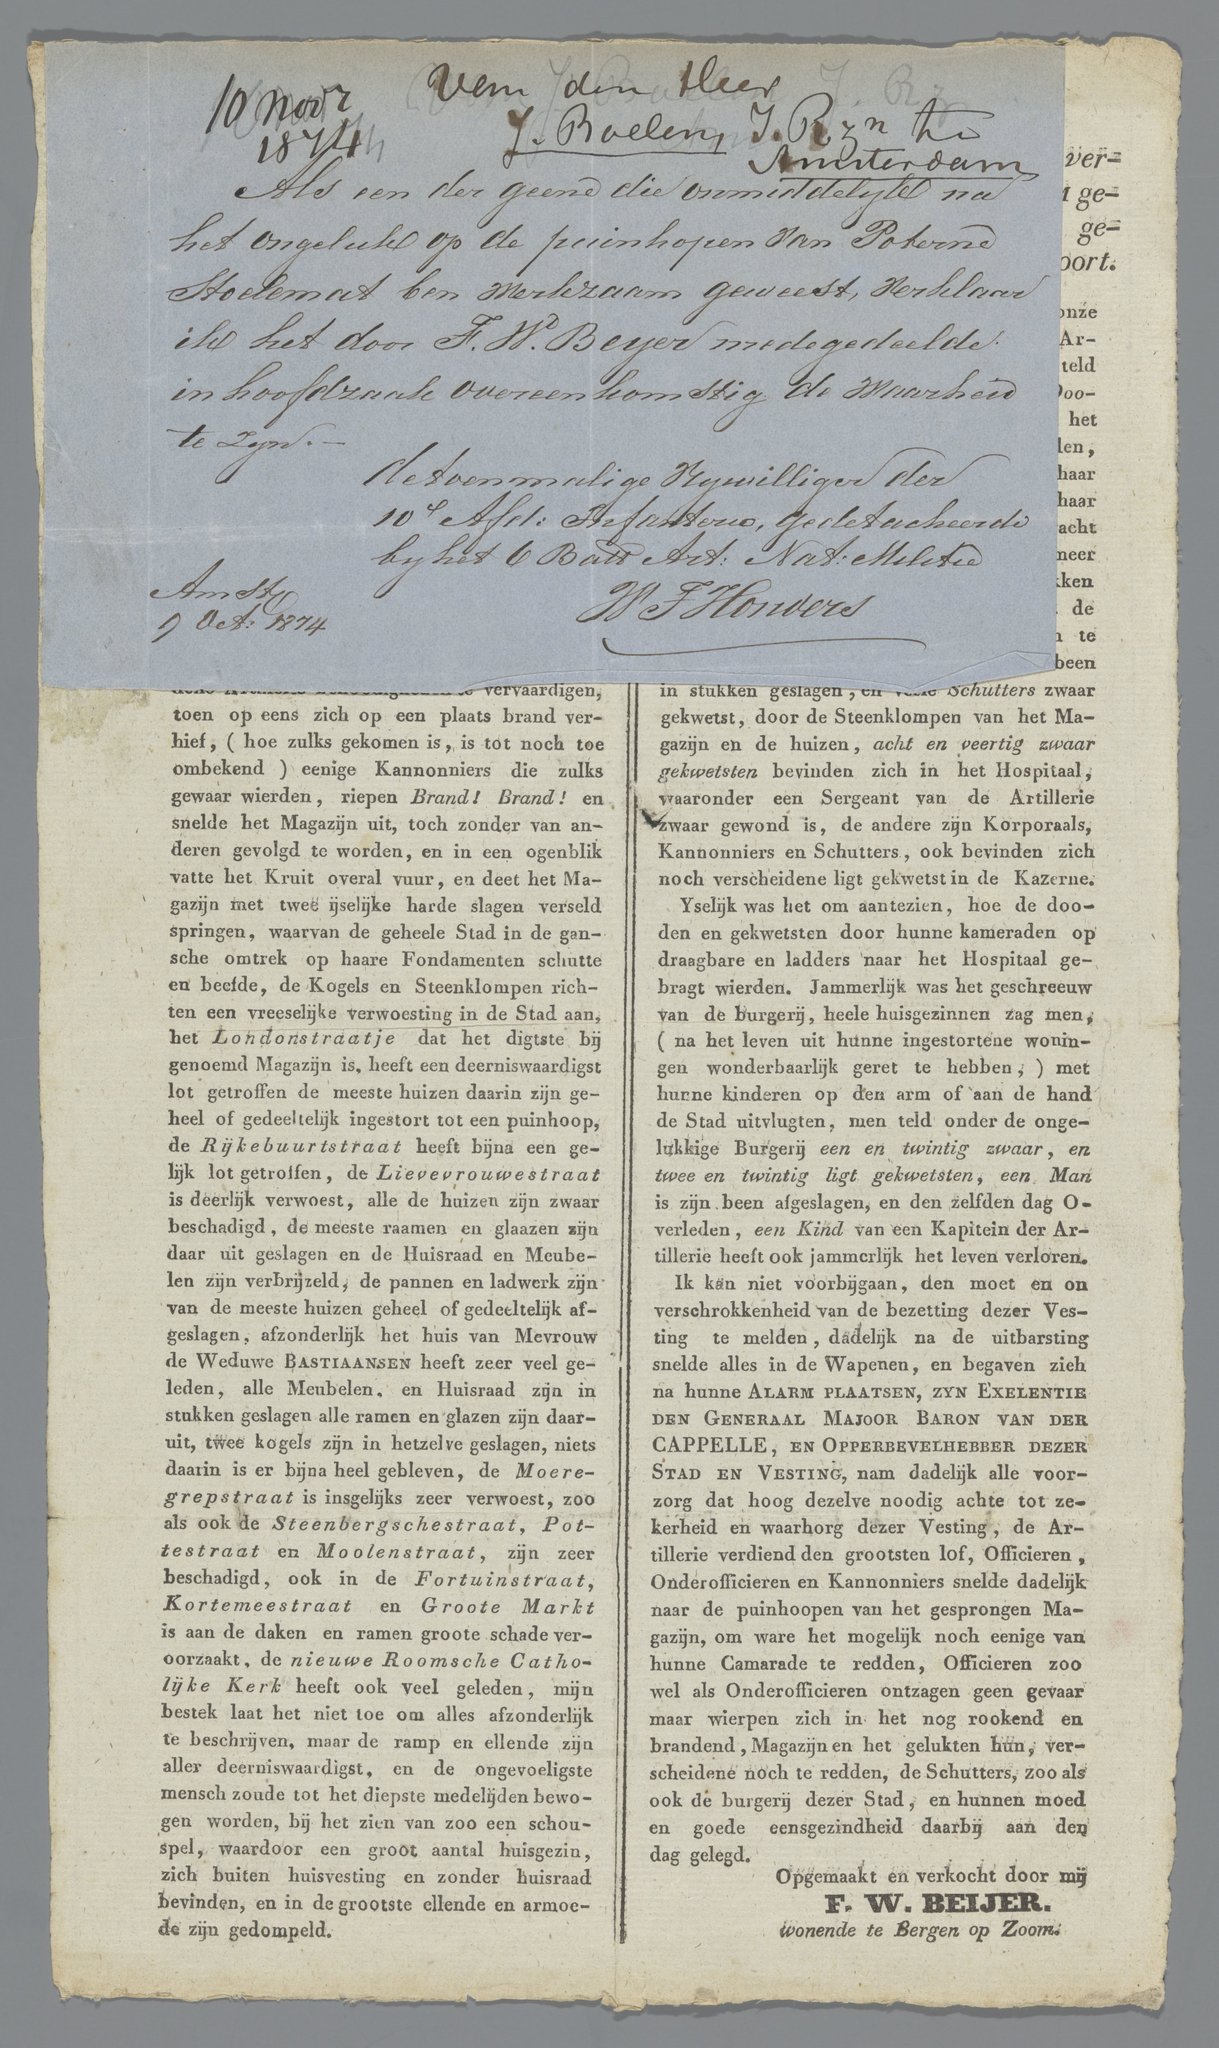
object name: pamphlet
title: Officiële en naar waarheid opgenomen, berichten aan de Verschrikkelijken ramp, die de Stad en Vestiging Bergen op Zoom getroffen heeft......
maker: f.w. beijer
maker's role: publisher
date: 1831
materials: ink, paper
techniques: printing, writing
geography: bergen op zoom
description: Eénzijdige bedrukt vel papier, in 2 kolommen, met vastgeplakt l.b. blauw papier, met pen beschreven, waar de juistheid van de mededeling wordt bevestigd.